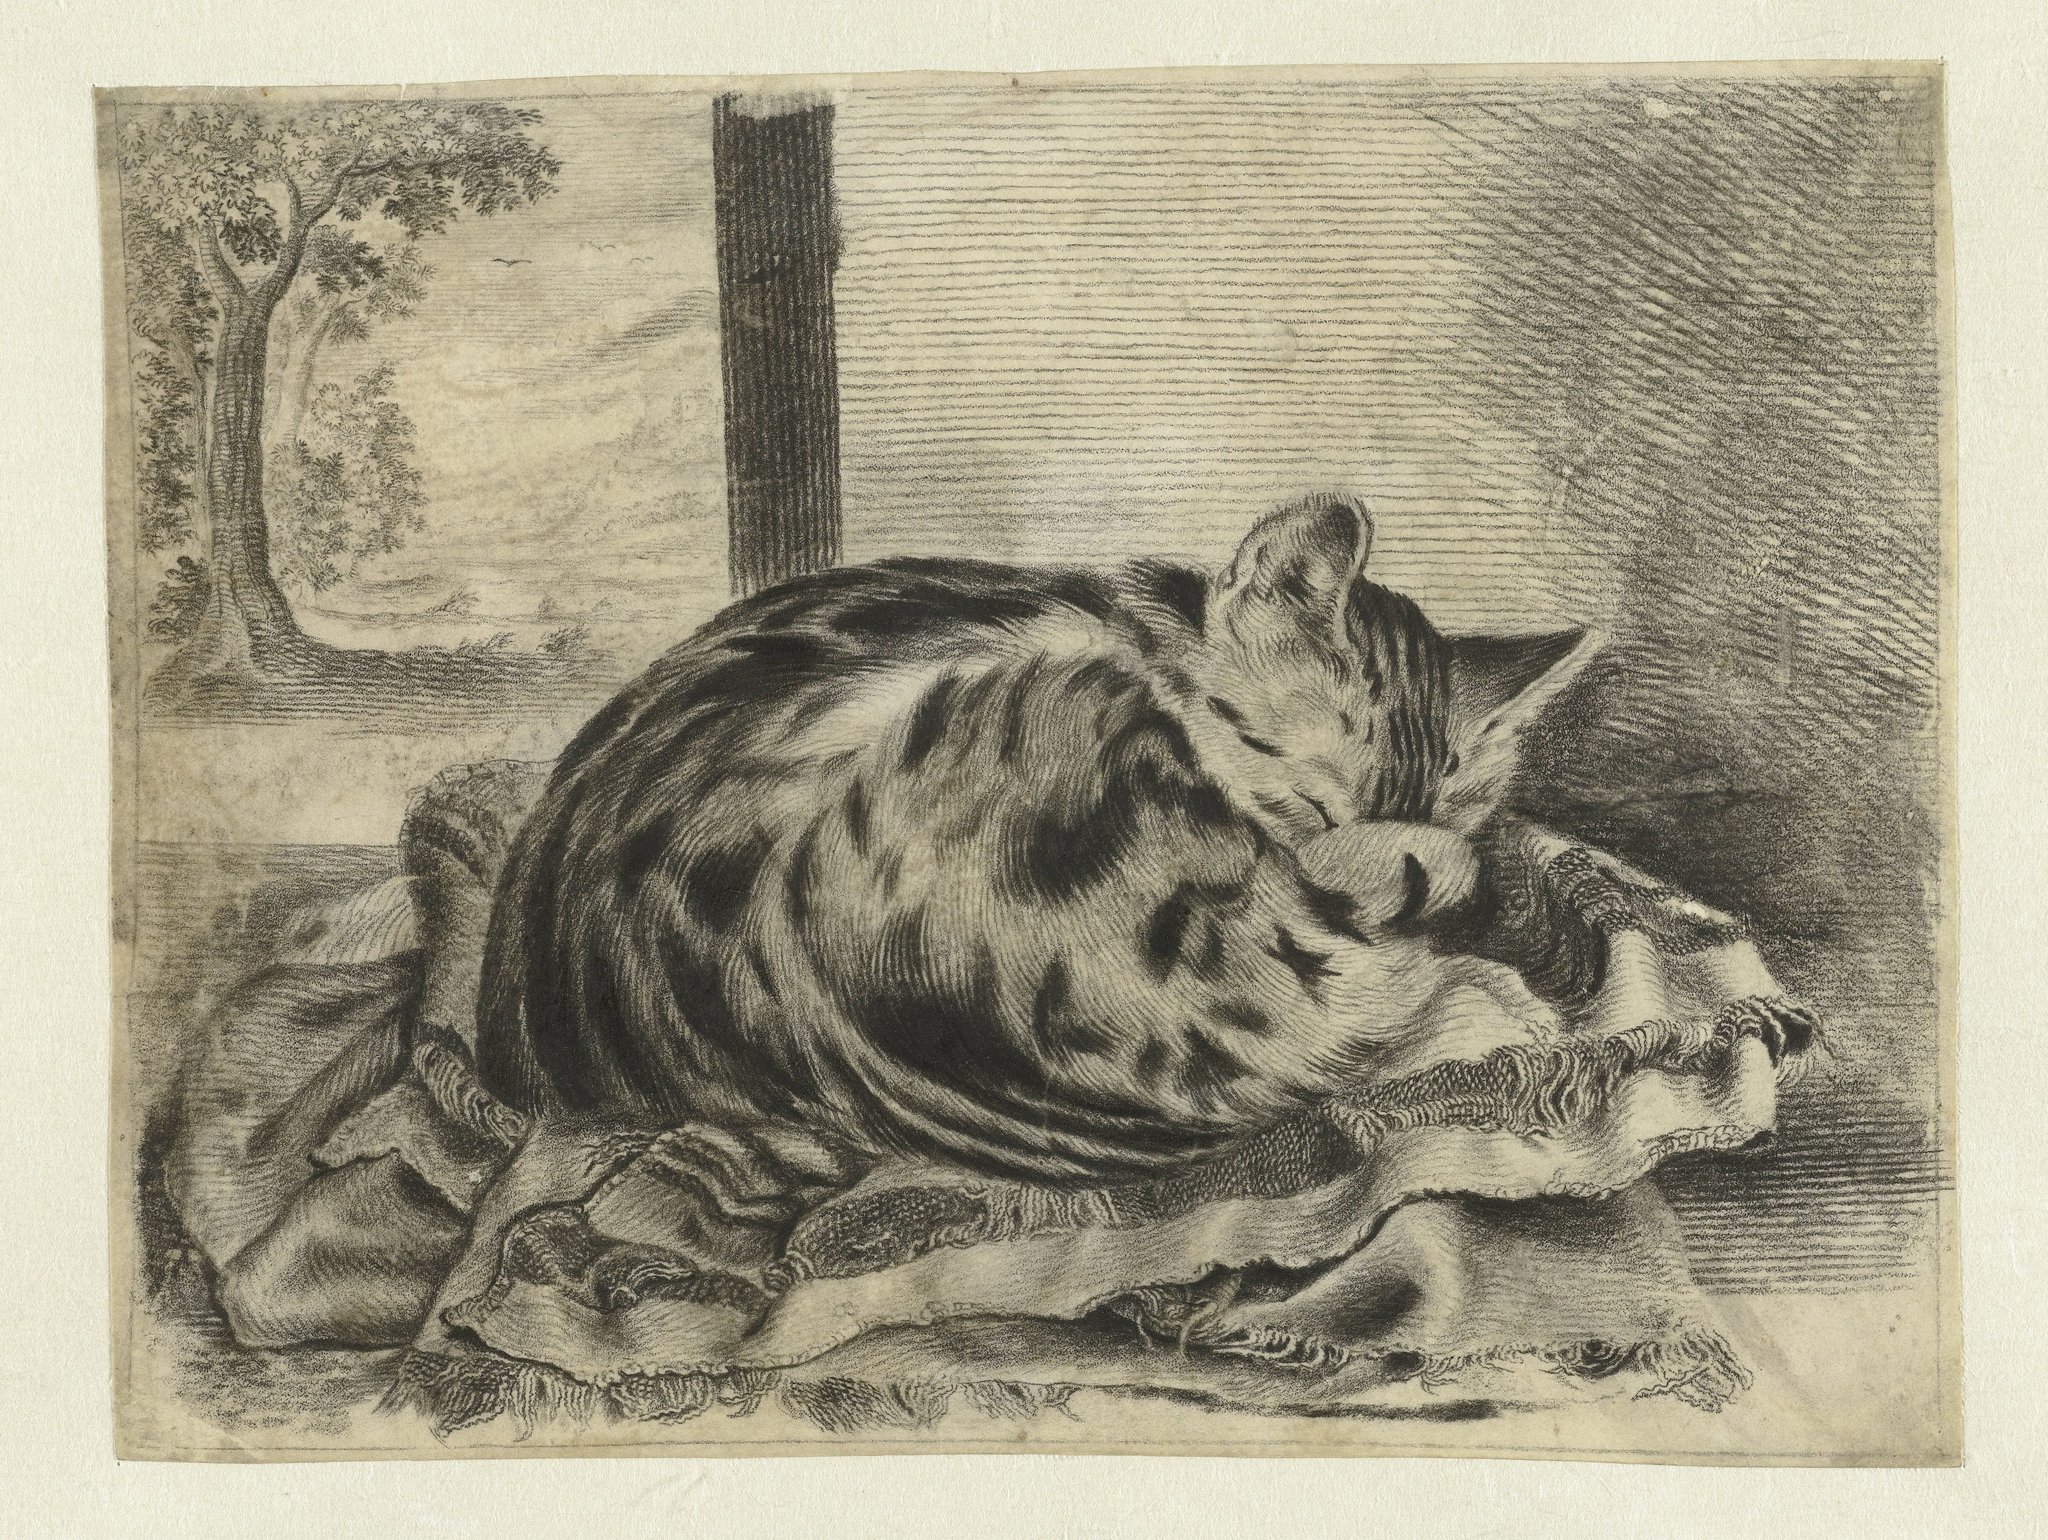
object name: drawing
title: Slapende poes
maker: Anonymous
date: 1690-1700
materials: chalk, parchment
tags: cat, sleeping; unconsciousness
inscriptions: : Lugt 240